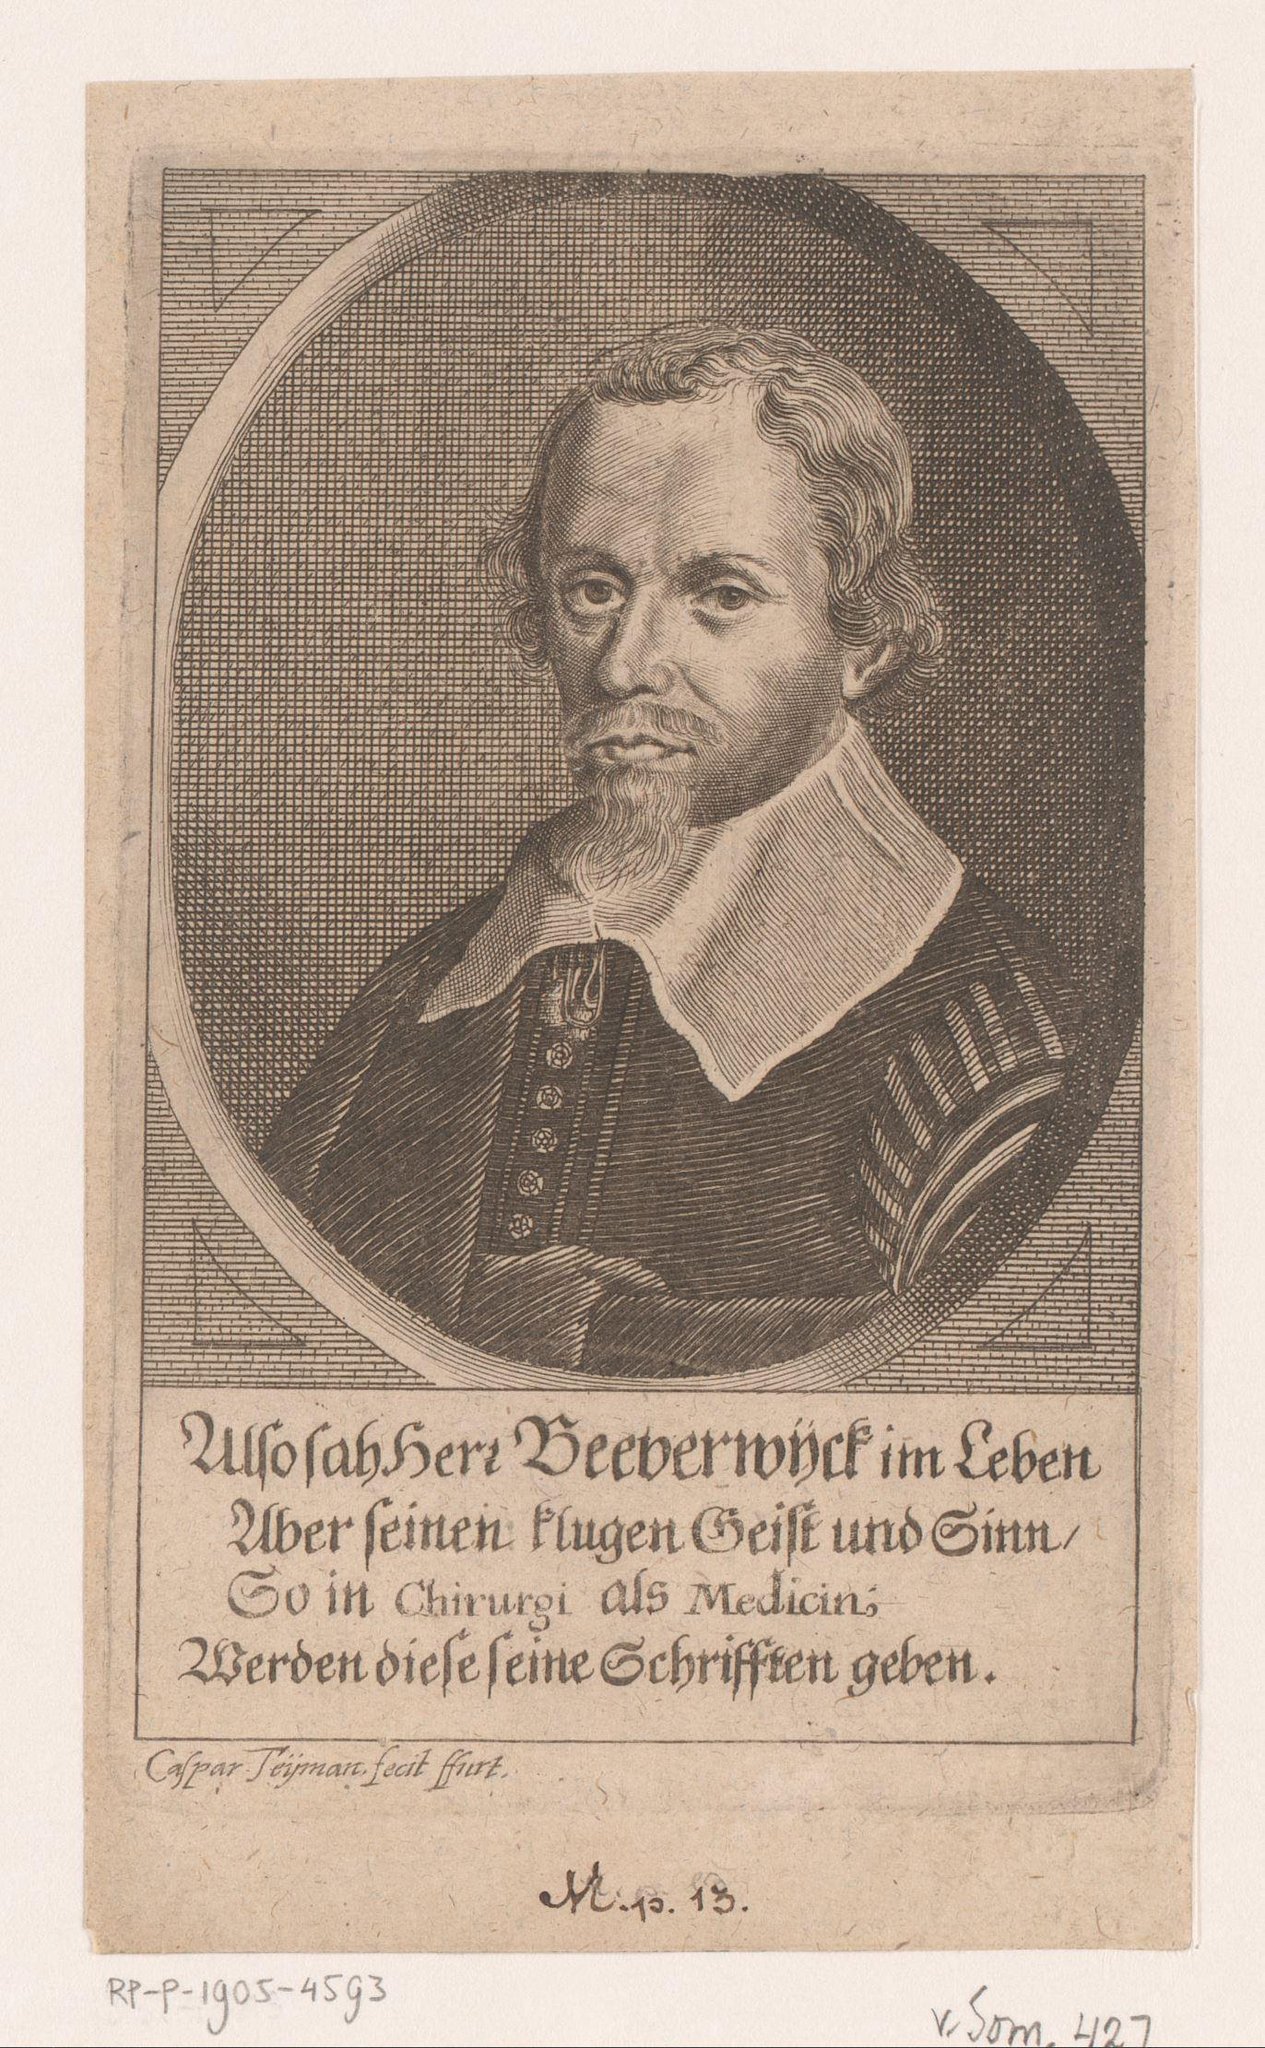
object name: print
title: Portret van Johannes van Beverwijck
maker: caspar teyman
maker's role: print maker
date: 1650-1699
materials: paper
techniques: engraving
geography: frankfurt am main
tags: dordrecht, johan van beverwijck, historical persons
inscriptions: collector's mark: Lugt 2228, number: ‘[...] 10.13.’